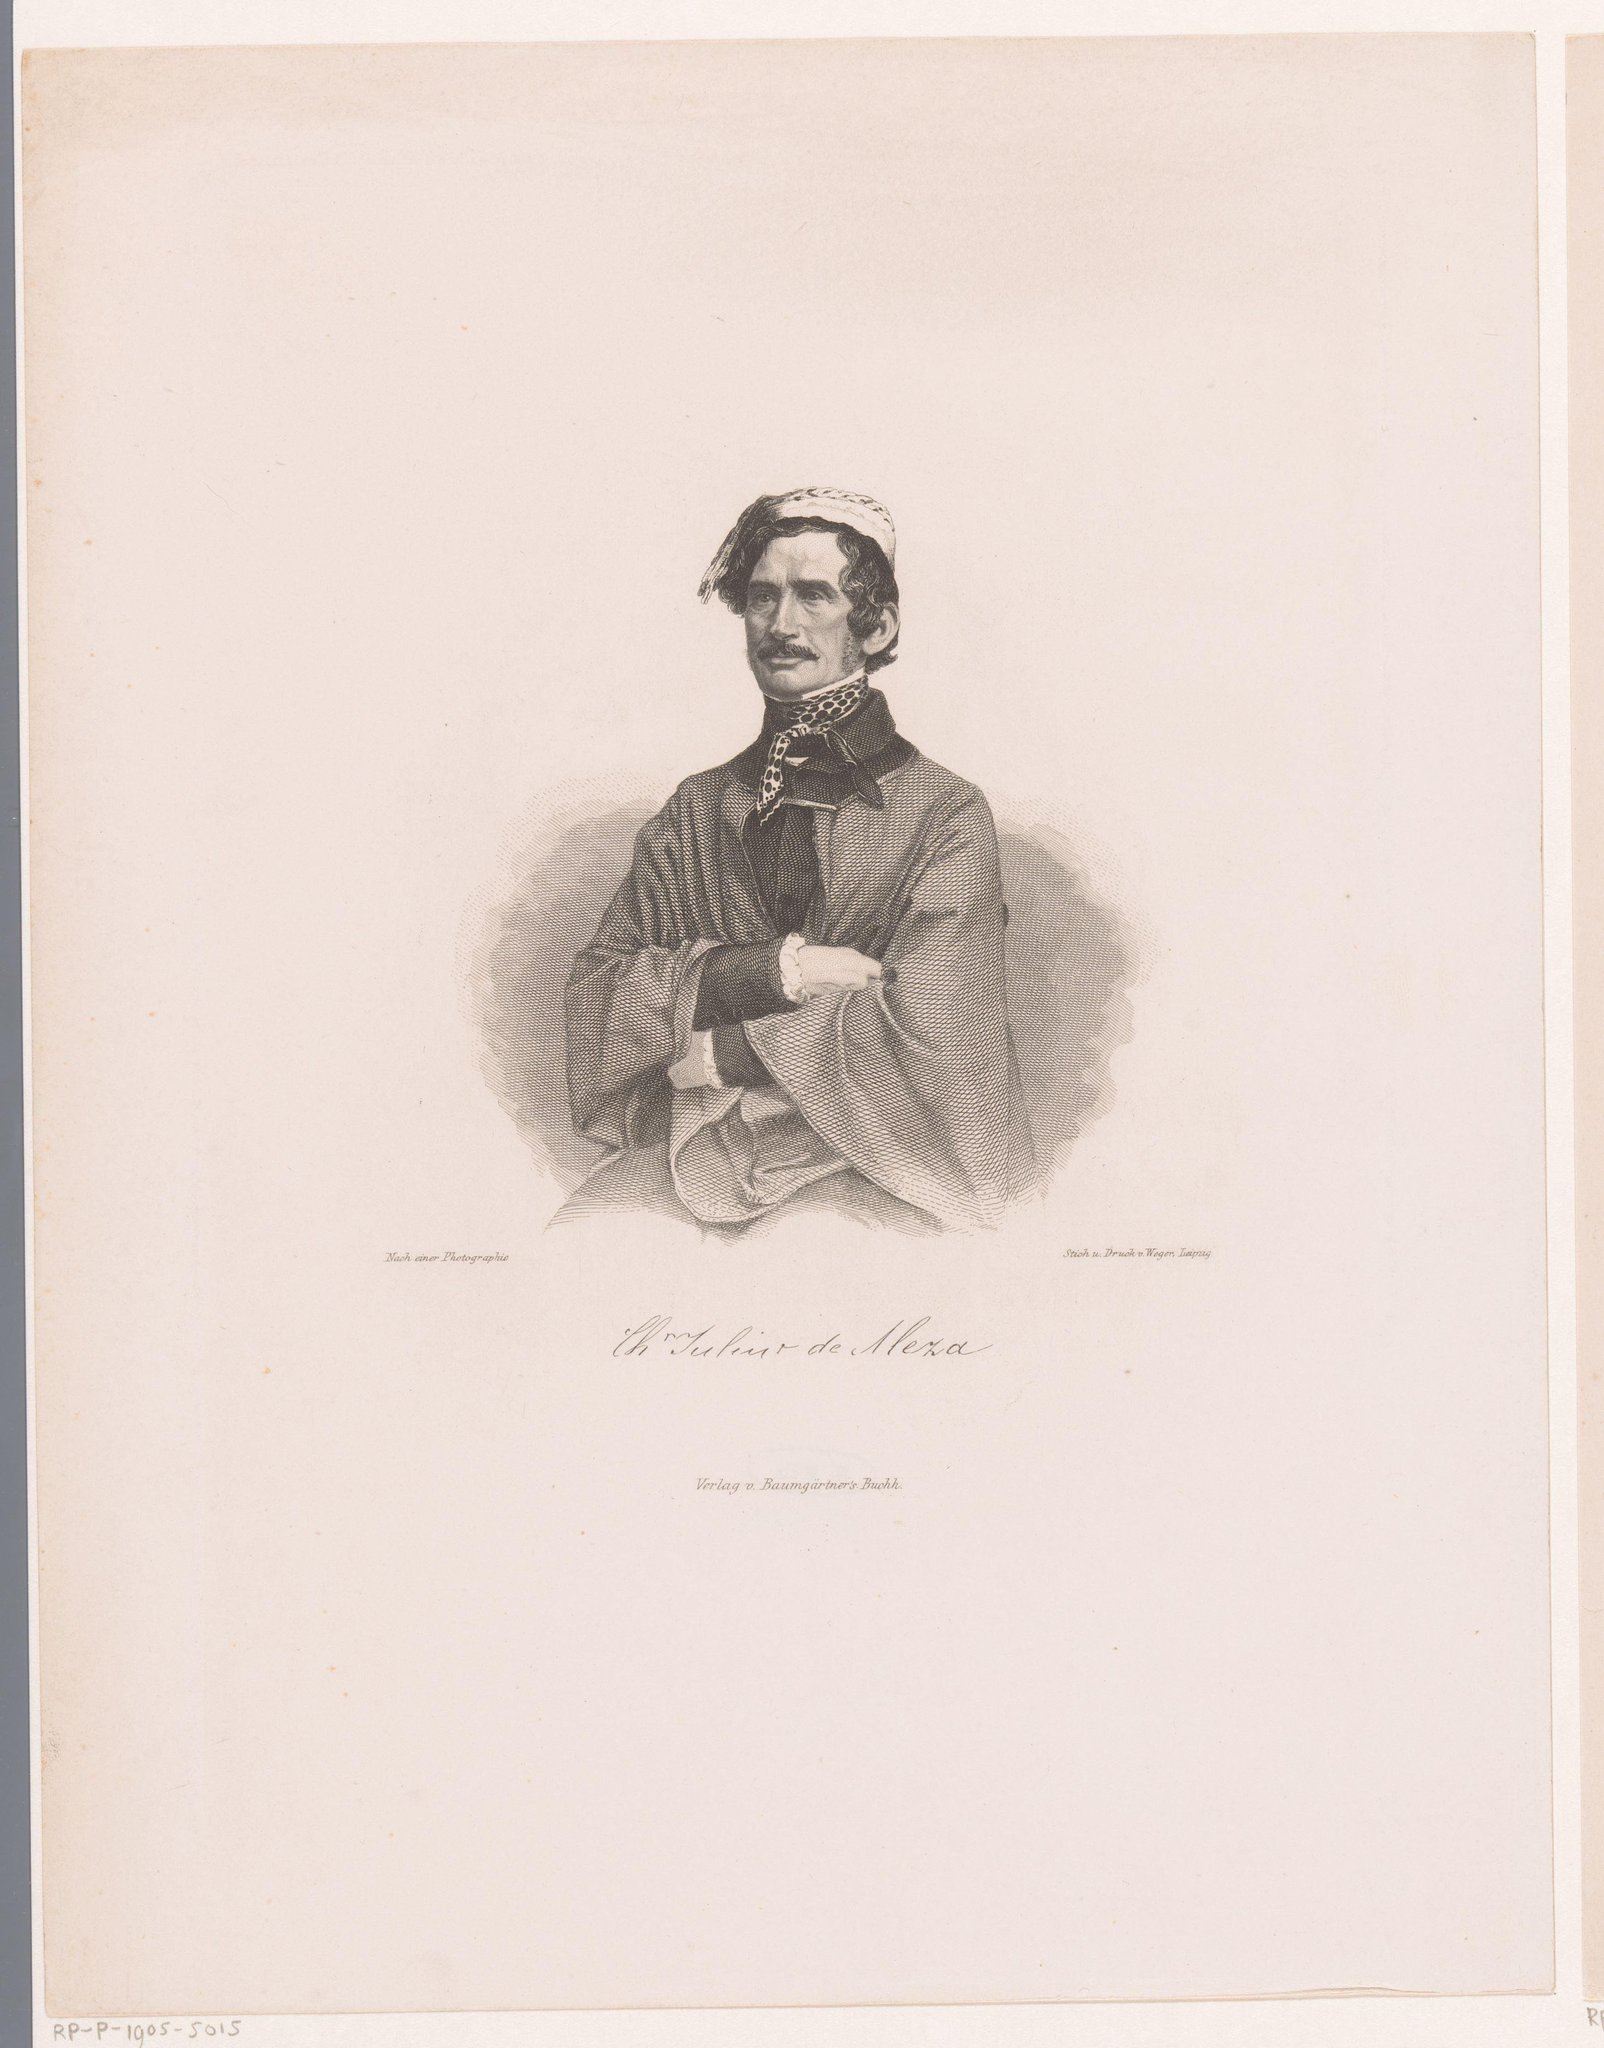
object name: print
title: Portret van Christian de Meza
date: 1849-1892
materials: paper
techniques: engraving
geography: leipzig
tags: denmark, copenhagen (city), historical persons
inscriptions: collector's mark: Lugt 2228